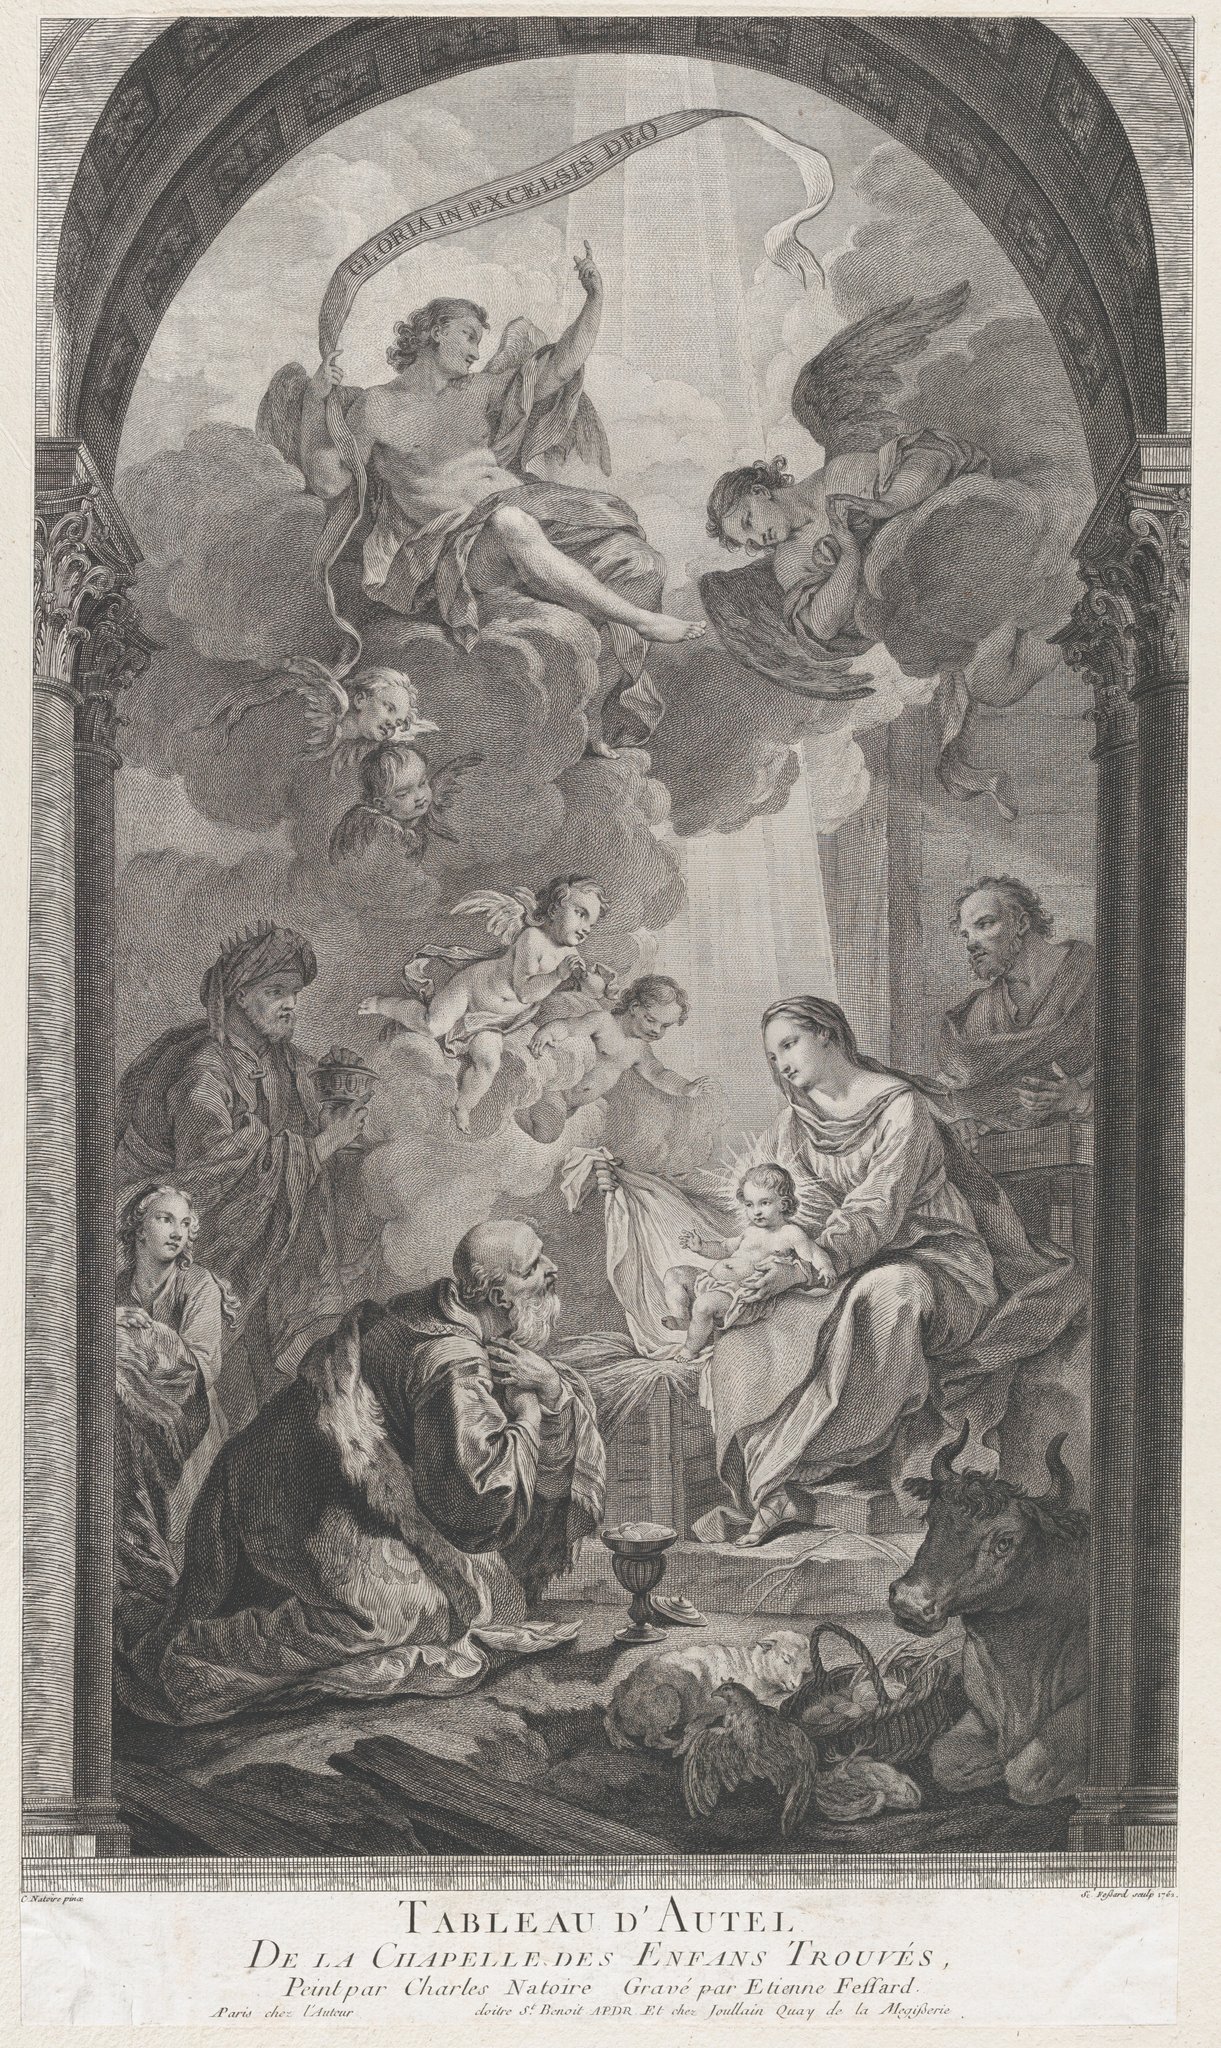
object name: print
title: The Chapel of the Enfants-Trouvés in Paris: Les Rois mages Gaspard et Melchoir adorant l'Enfant Jésus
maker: etienne fessard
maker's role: artist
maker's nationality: french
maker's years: 1714-1777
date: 1752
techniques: engraving, etching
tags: angels,virgin mary,jesus,adoration of the magi